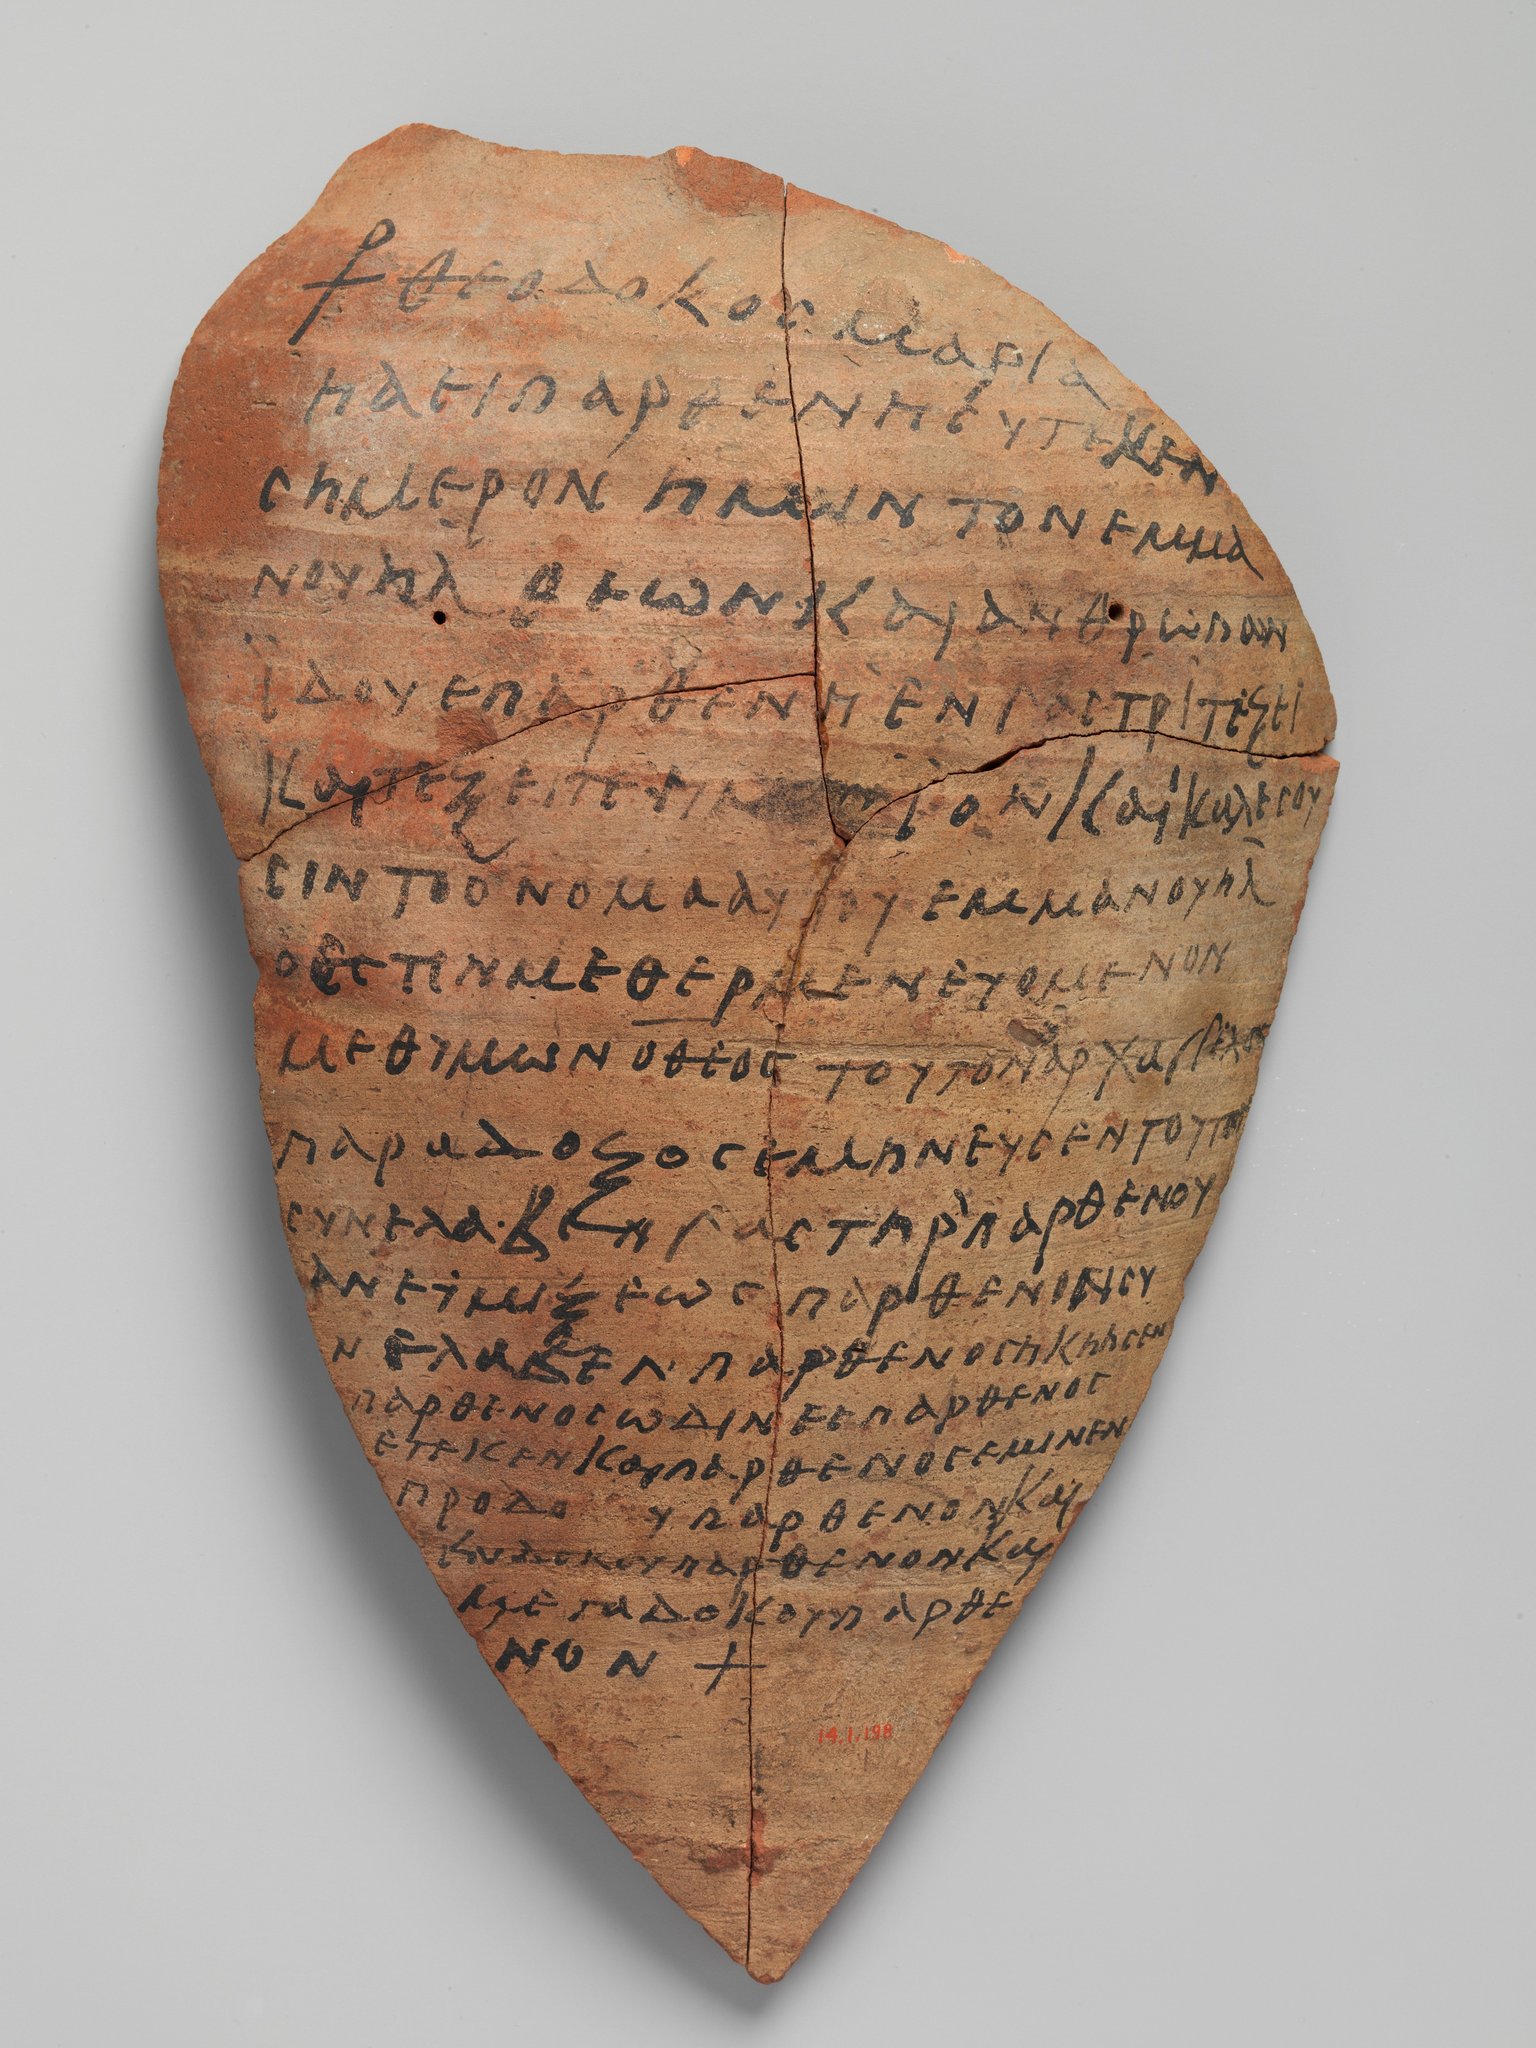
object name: ostrakon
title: Ostrakon with a Troparion (Early Hymn)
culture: coptic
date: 580-640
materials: ink, pottery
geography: egypt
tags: coptic,documents